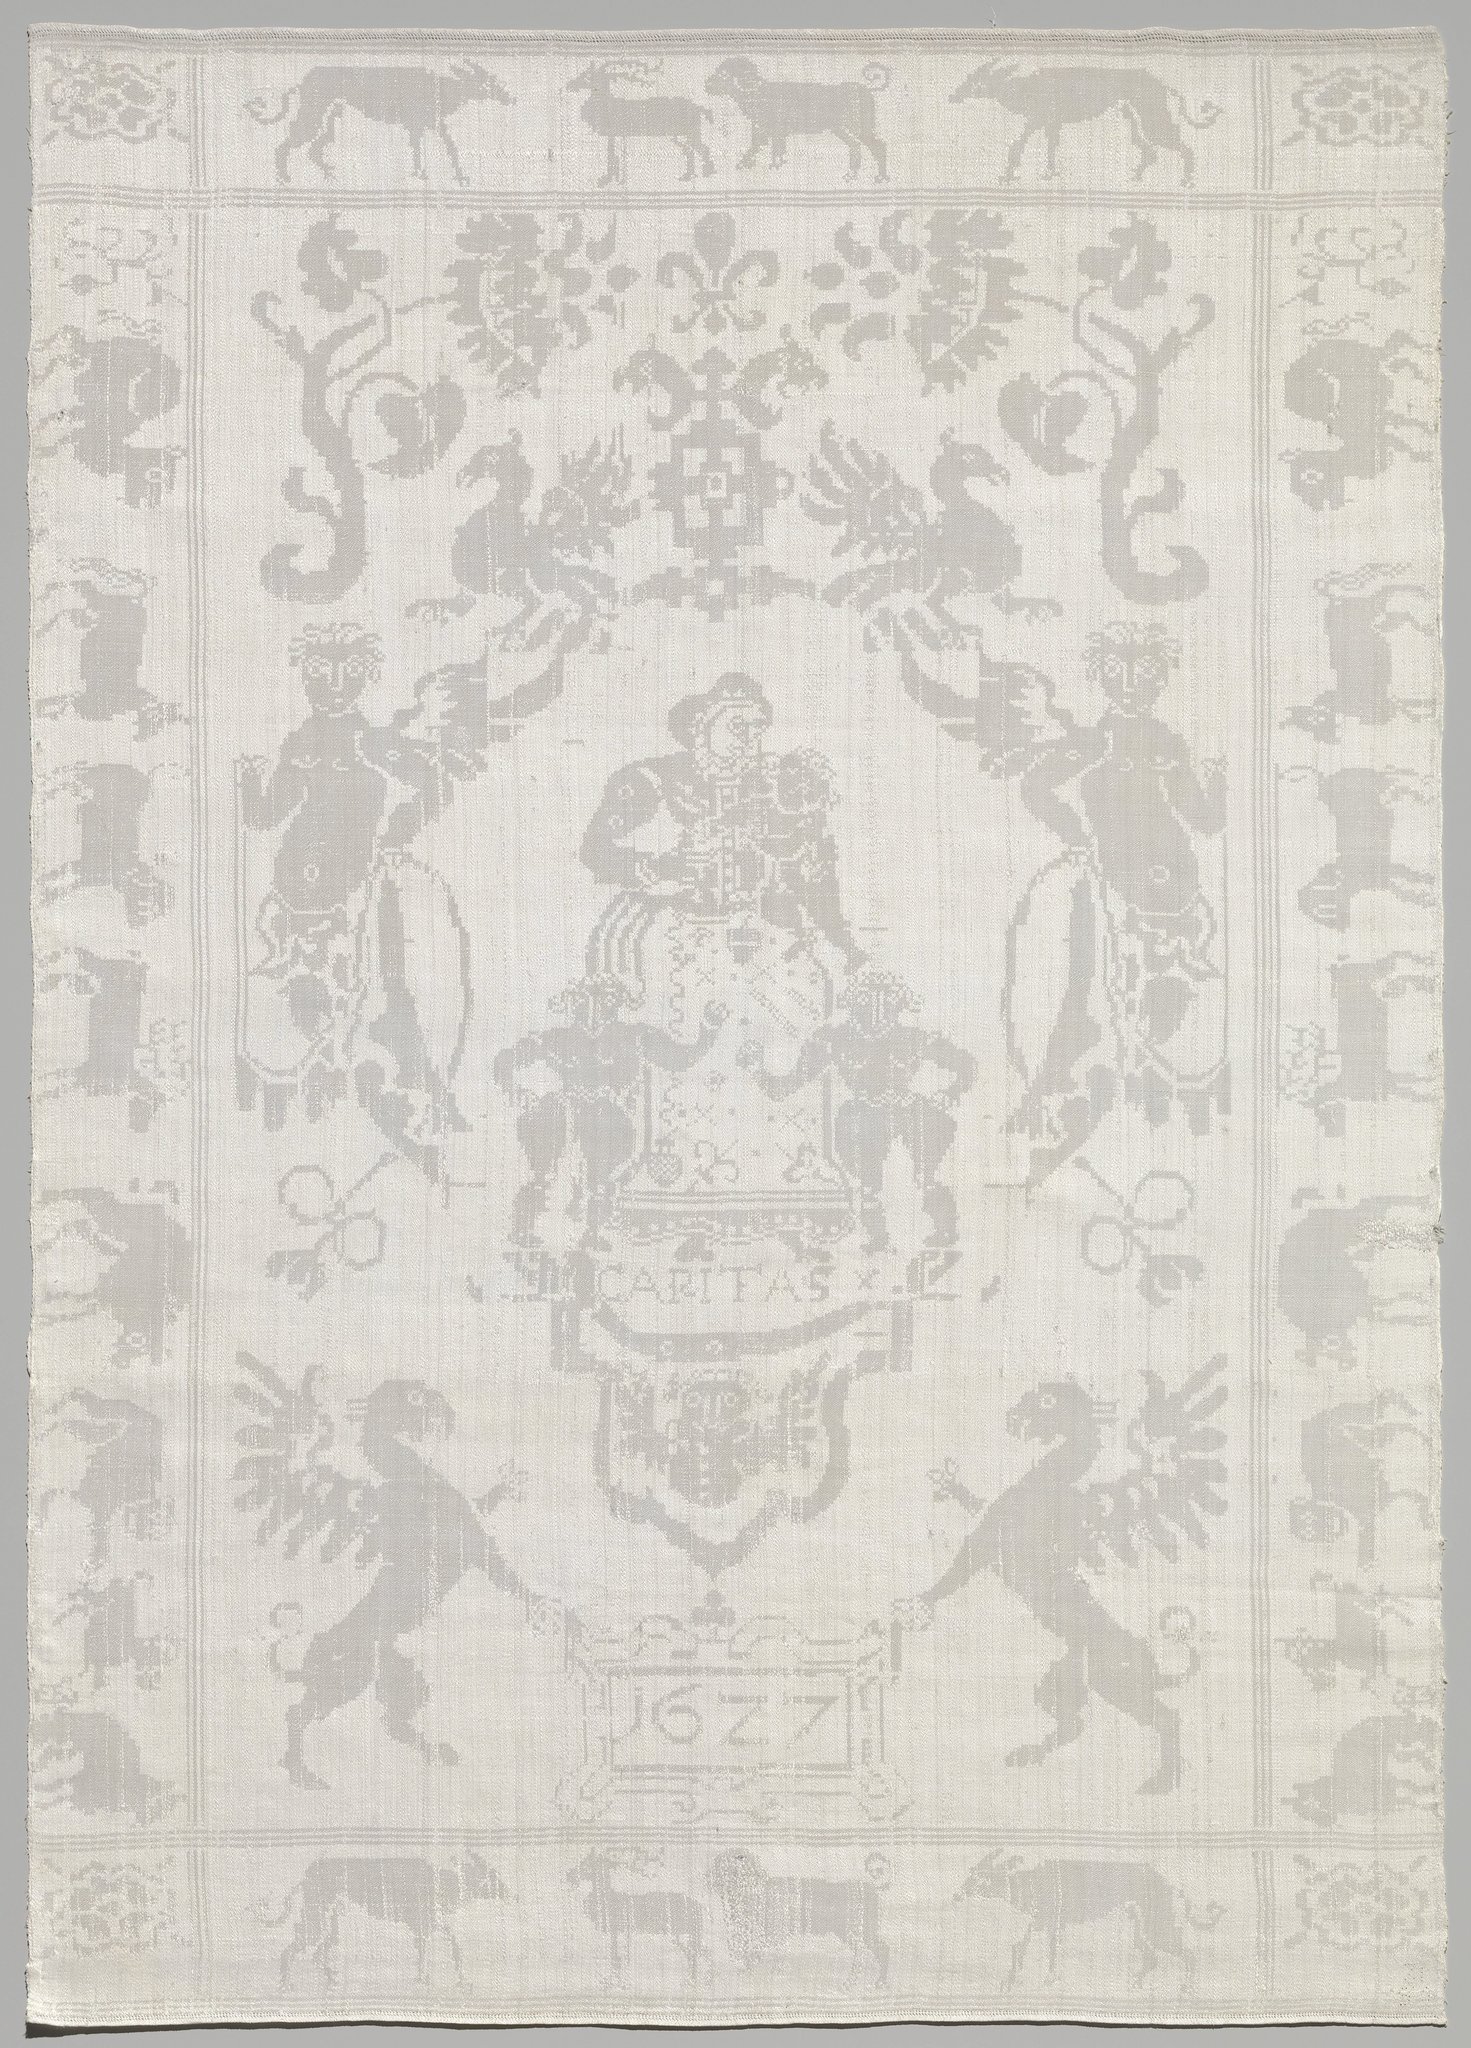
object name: napkin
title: Servet met Caritas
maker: Anonymous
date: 1627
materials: linen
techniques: damask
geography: southern netherlands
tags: charity, 'caritas'; 'carità' (ripa) ~ one of the three theological virtues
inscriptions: mark: ‘CB 12’, mark: ‘EA’, mark: ‘M’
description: Servet van linnendamast met Caritas als een staande vrouw met een kind aan elke zijde. Middenveld: Het symmetrisch verdubbeld patroon vertoont het volgende tafereel: In het midden staat een vrouwenfiguur met kleine gepijpte kraag, gladde mouwen met bragoenen en een nauwsluitend lijf en twee rokken die wijd uitstaan over een fardegalijn; van de ceintuur hangt een slingerend koord met beurs (?). Zij buigt het hoofd naar links, waar zij een kind op de arm houdt. Aan haar rechterzijde staat een kind dat symmetrisch herhaald is. Het onderschrift CARITAS wordt gehouden door klimmende griffioenen. Links en rechts van de Caritas een engel, boven haar een vierkant met kruis en terzijde twee afgewende griffioenen. Geheel boven een fleur de lys en grote bloemtak. Staande en liggende randen: asymmetrisch gerangschikte dieren, zoals een hond, hert, bok, zwijn, paard, kameel, die in de staande randen naar binnen gericht staan. Geen blokkenrand. Hoeken: roos. Zoom: dubbel open zoom.